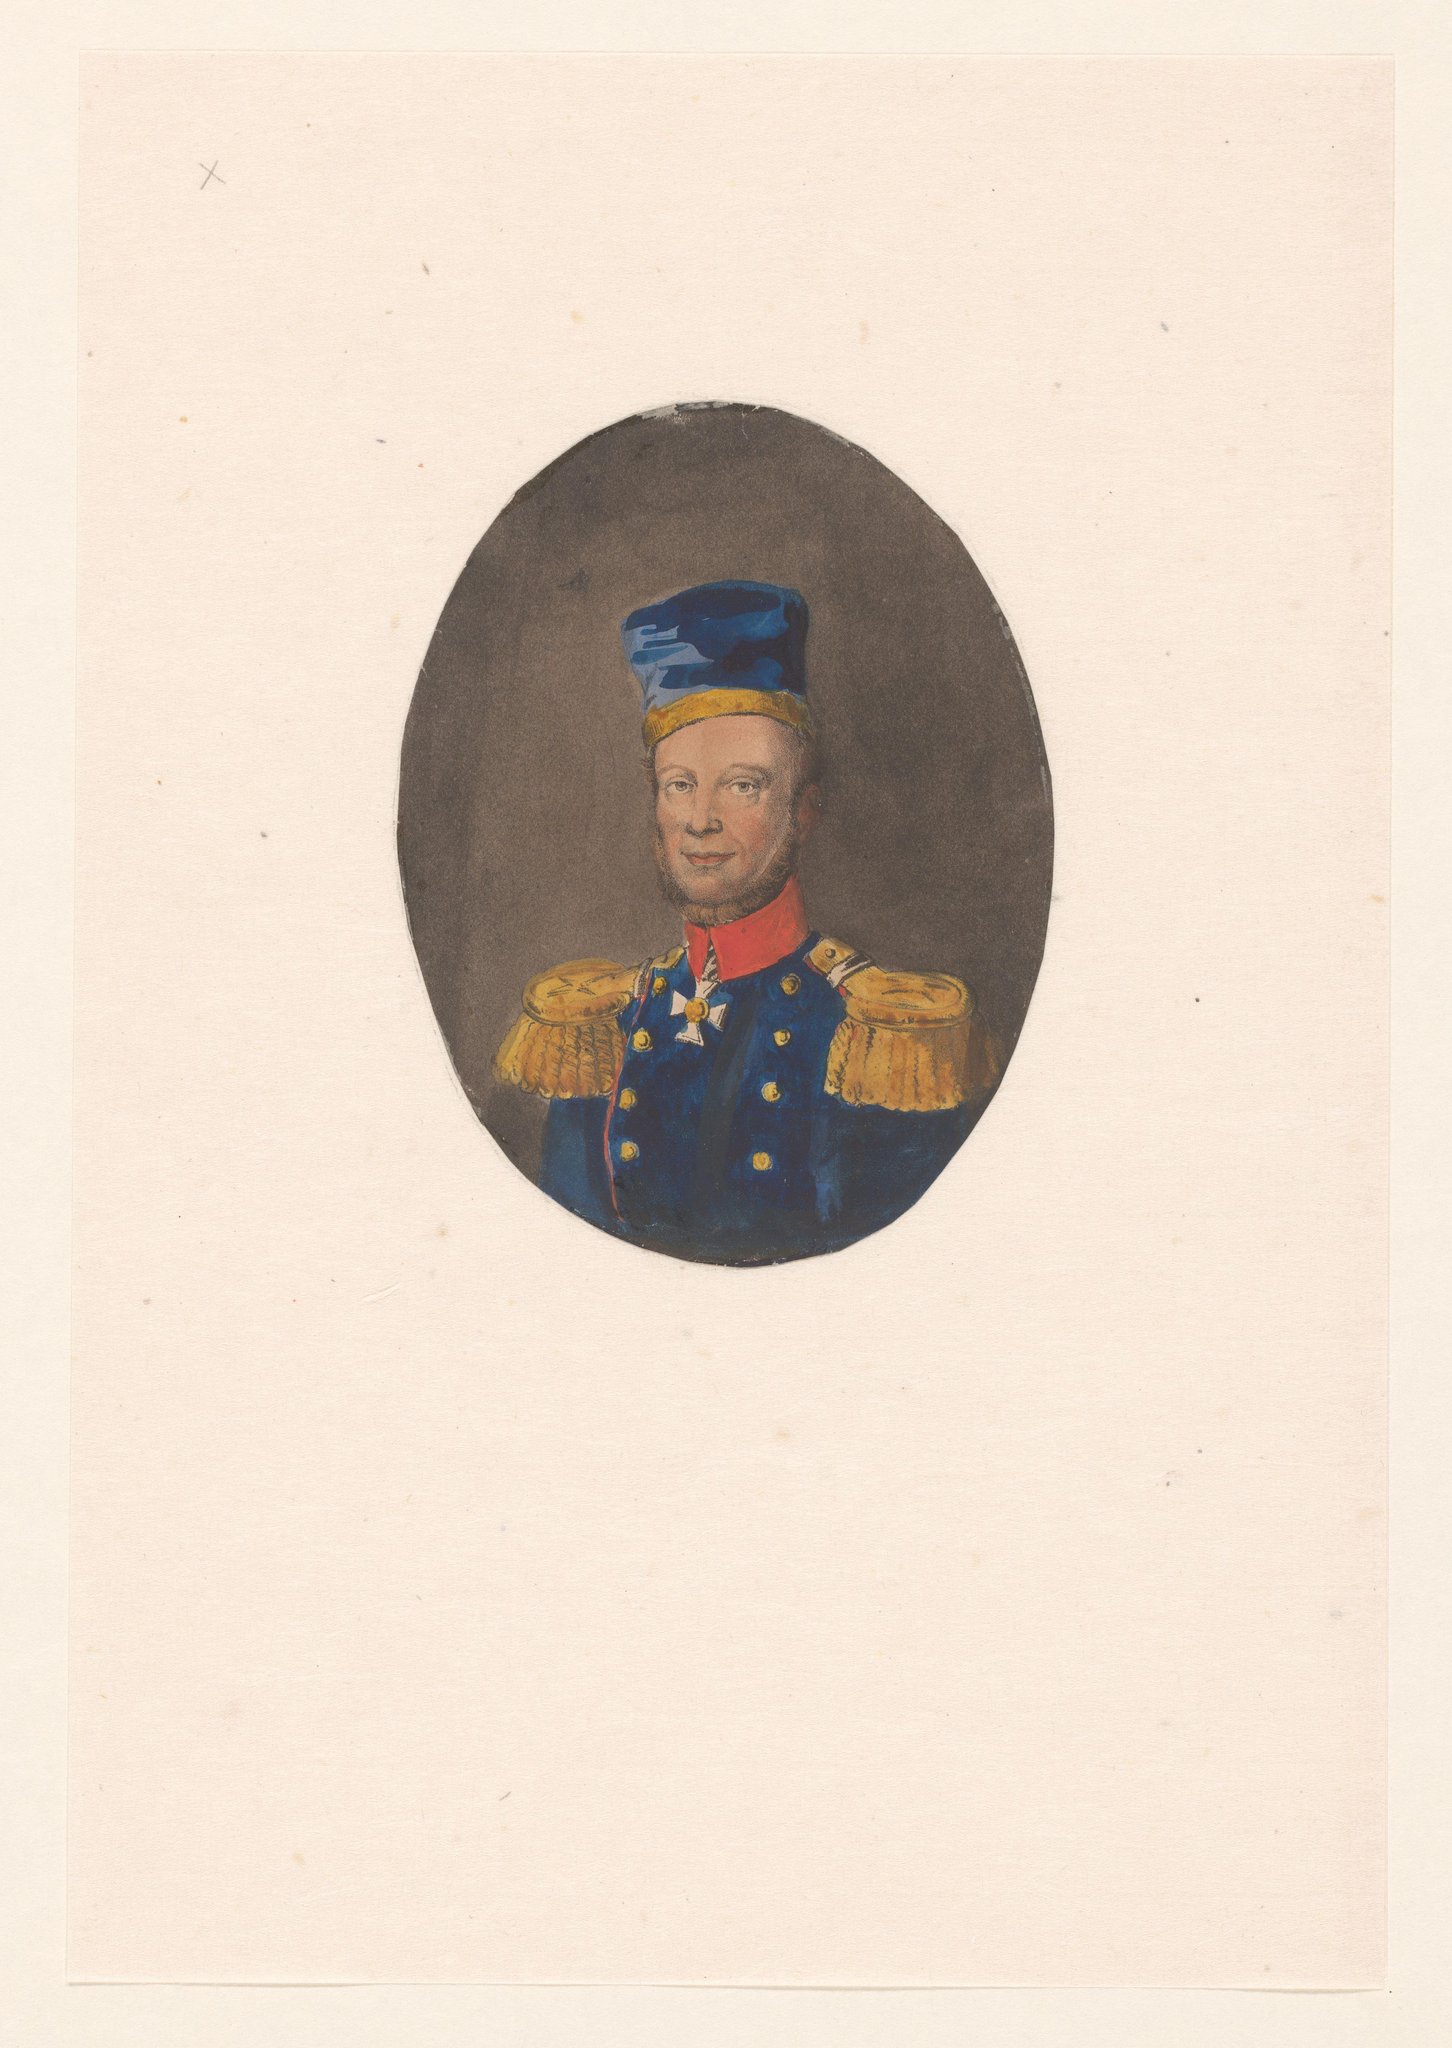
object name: print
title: Koning Willem II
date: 1849-1850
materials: paper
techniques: hand coloring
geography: the hague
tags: william ii of the netherlands, historical persons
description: Ovaal uitgeknipt en ingekleurd portret van koning Willem II.